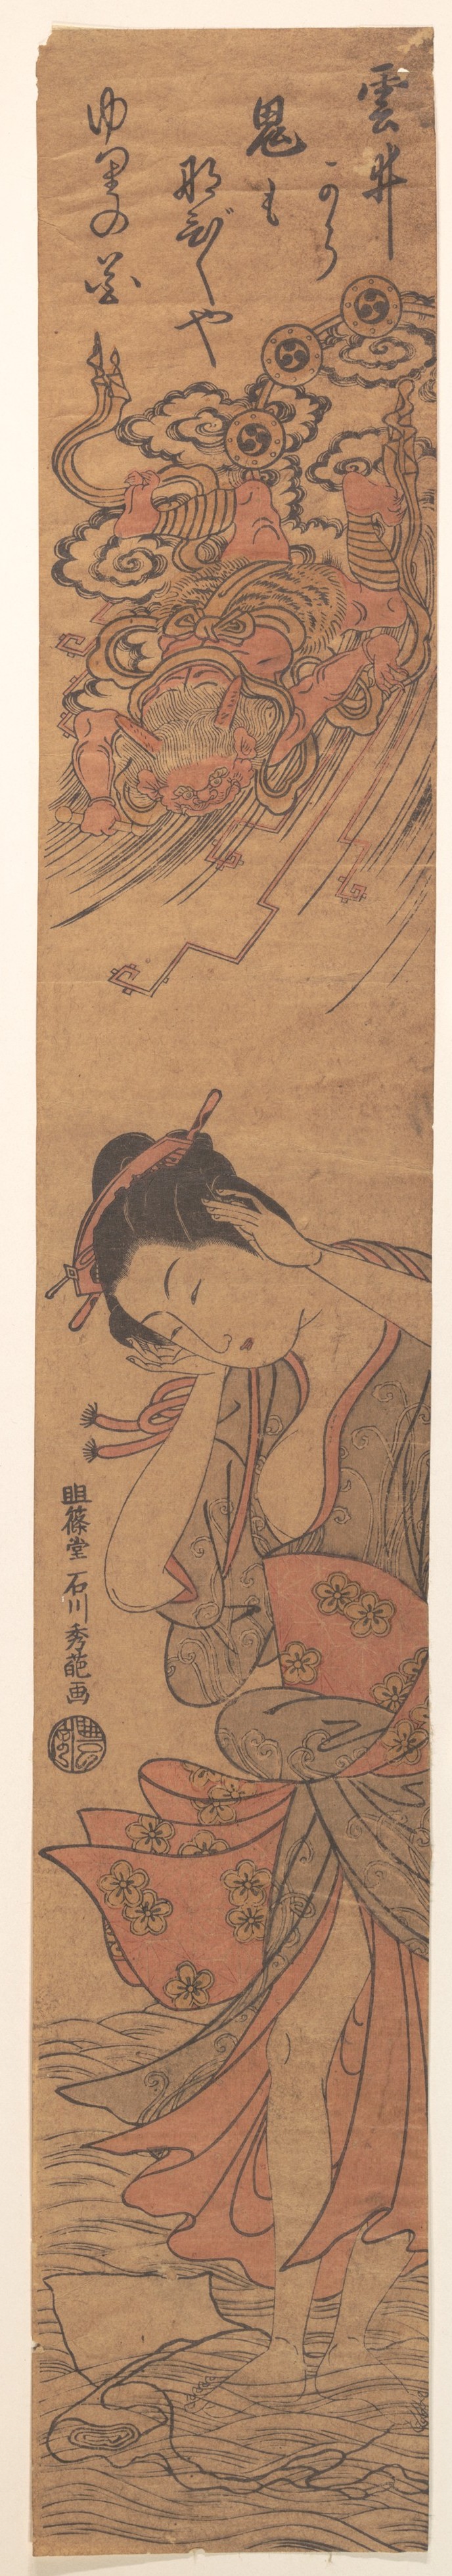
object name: woodblock print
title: Woman Washing Clothes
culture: japanese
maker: ishikawa toyonobu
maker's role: artist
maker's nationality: japanese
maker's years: 1711-1785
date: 1711-1785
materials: ink, paper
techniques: woodblock print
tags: women,washing,working